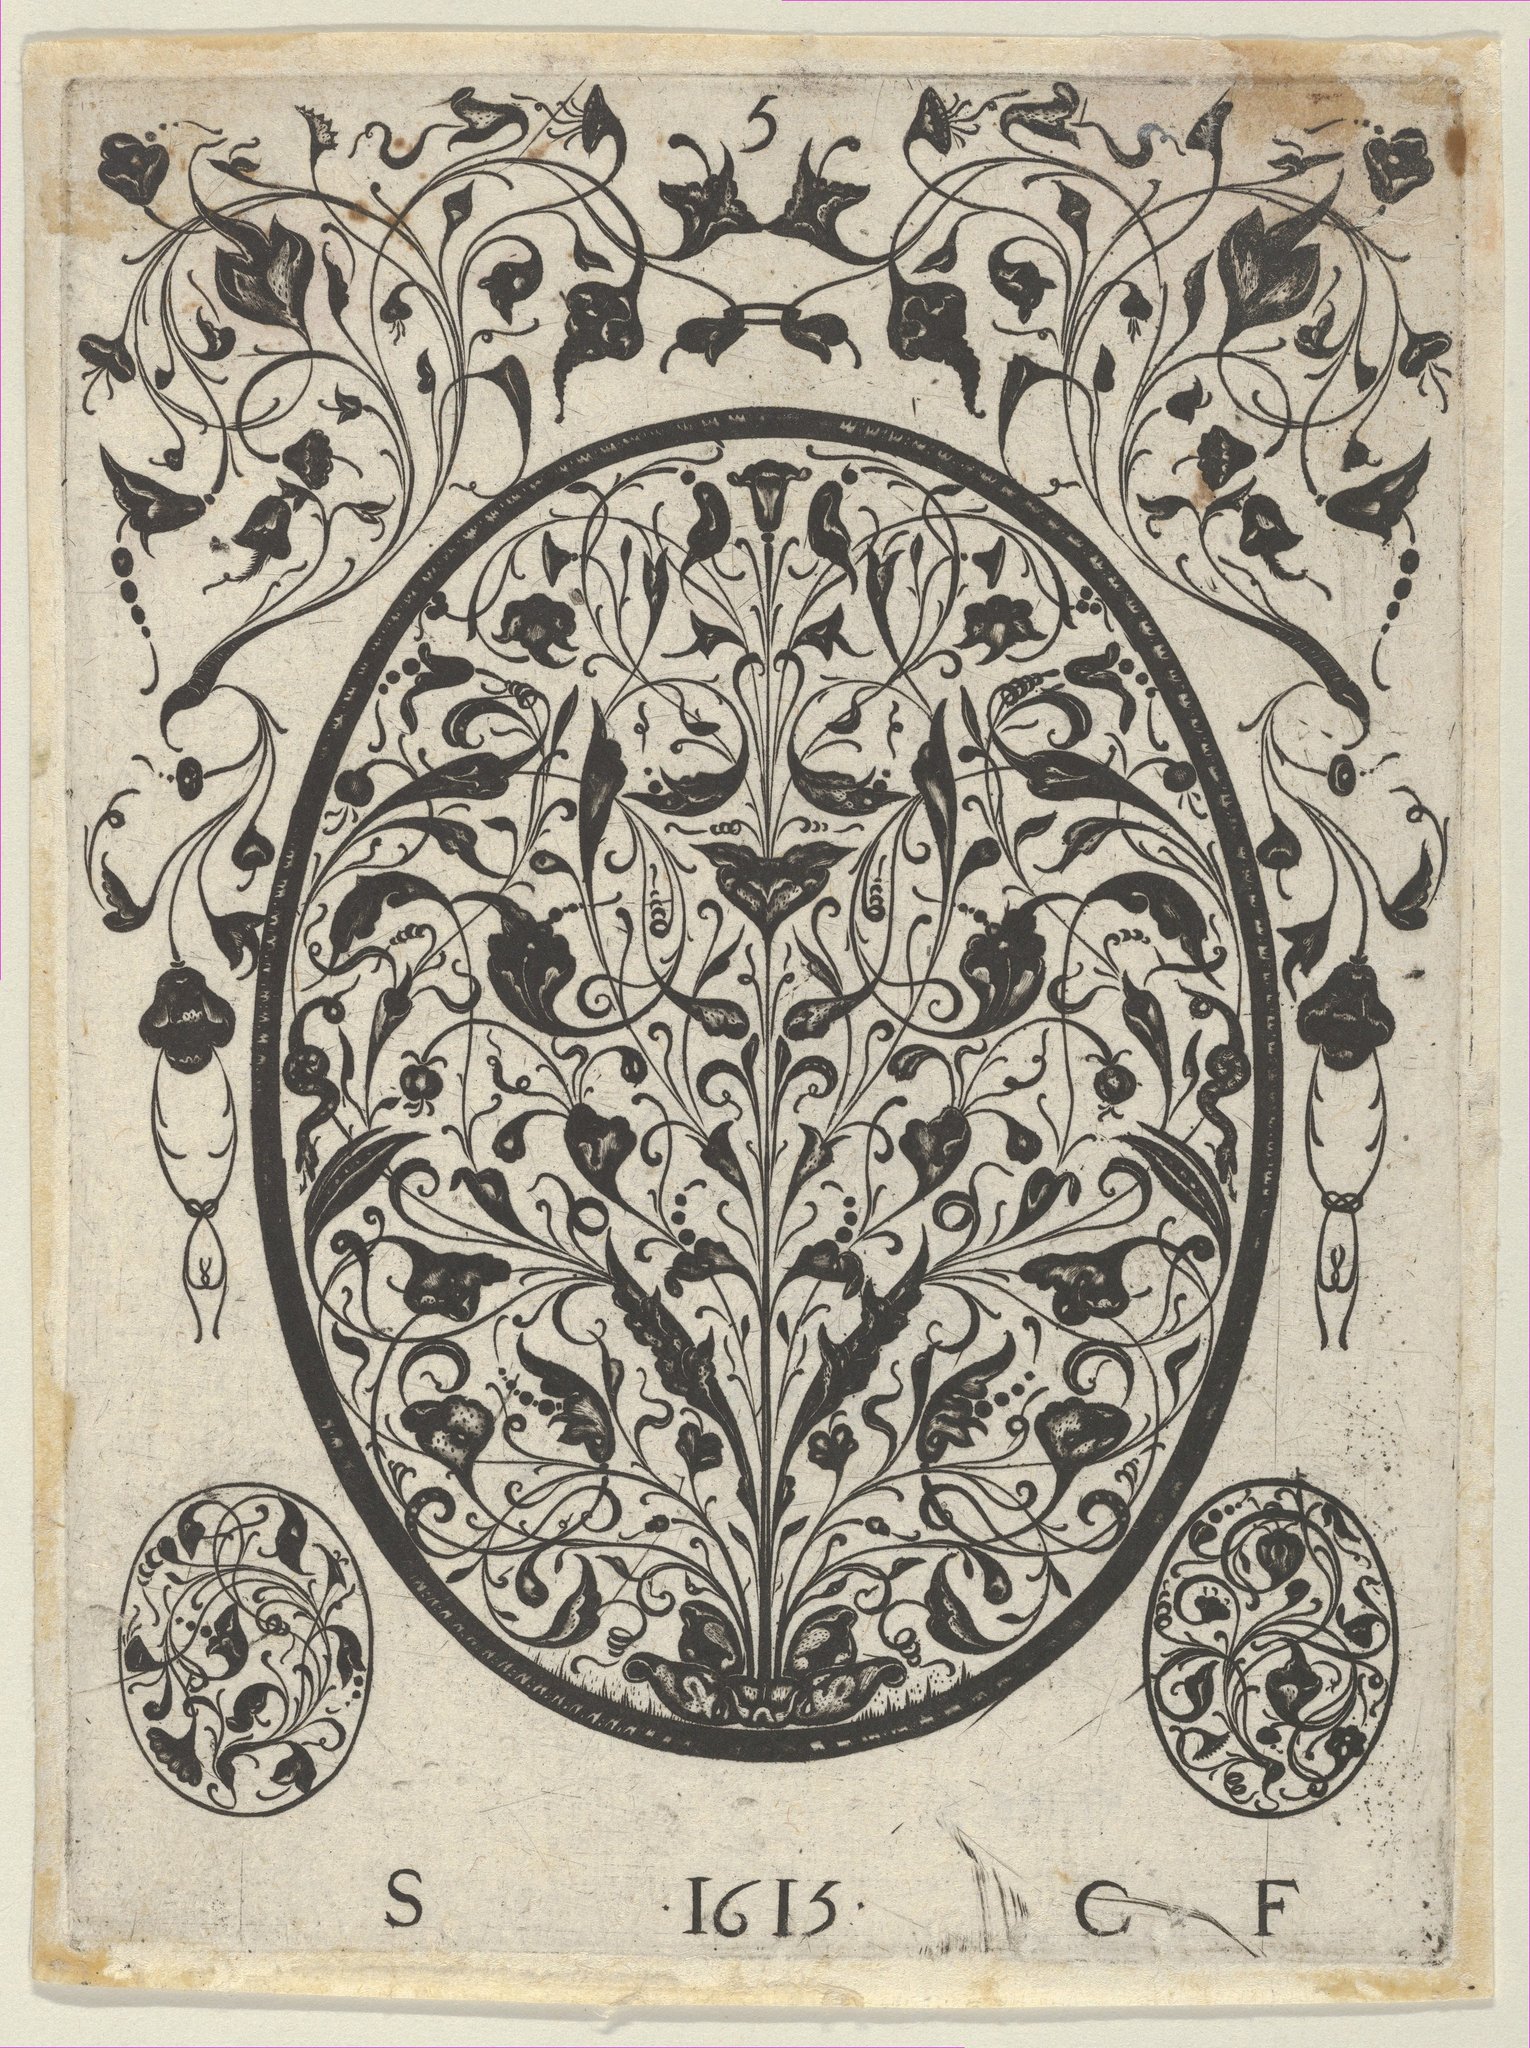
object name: print ornament architecture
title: Blackwork Print with Foliate Scrolls in an Oval at Center, from a Series of Blackwork Prints for Goldsmiths' Work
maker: etienne carteron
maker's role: artist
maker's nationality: french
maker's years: 1580-1680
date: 1615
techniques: embroidery, engraving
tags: flowers,leaves